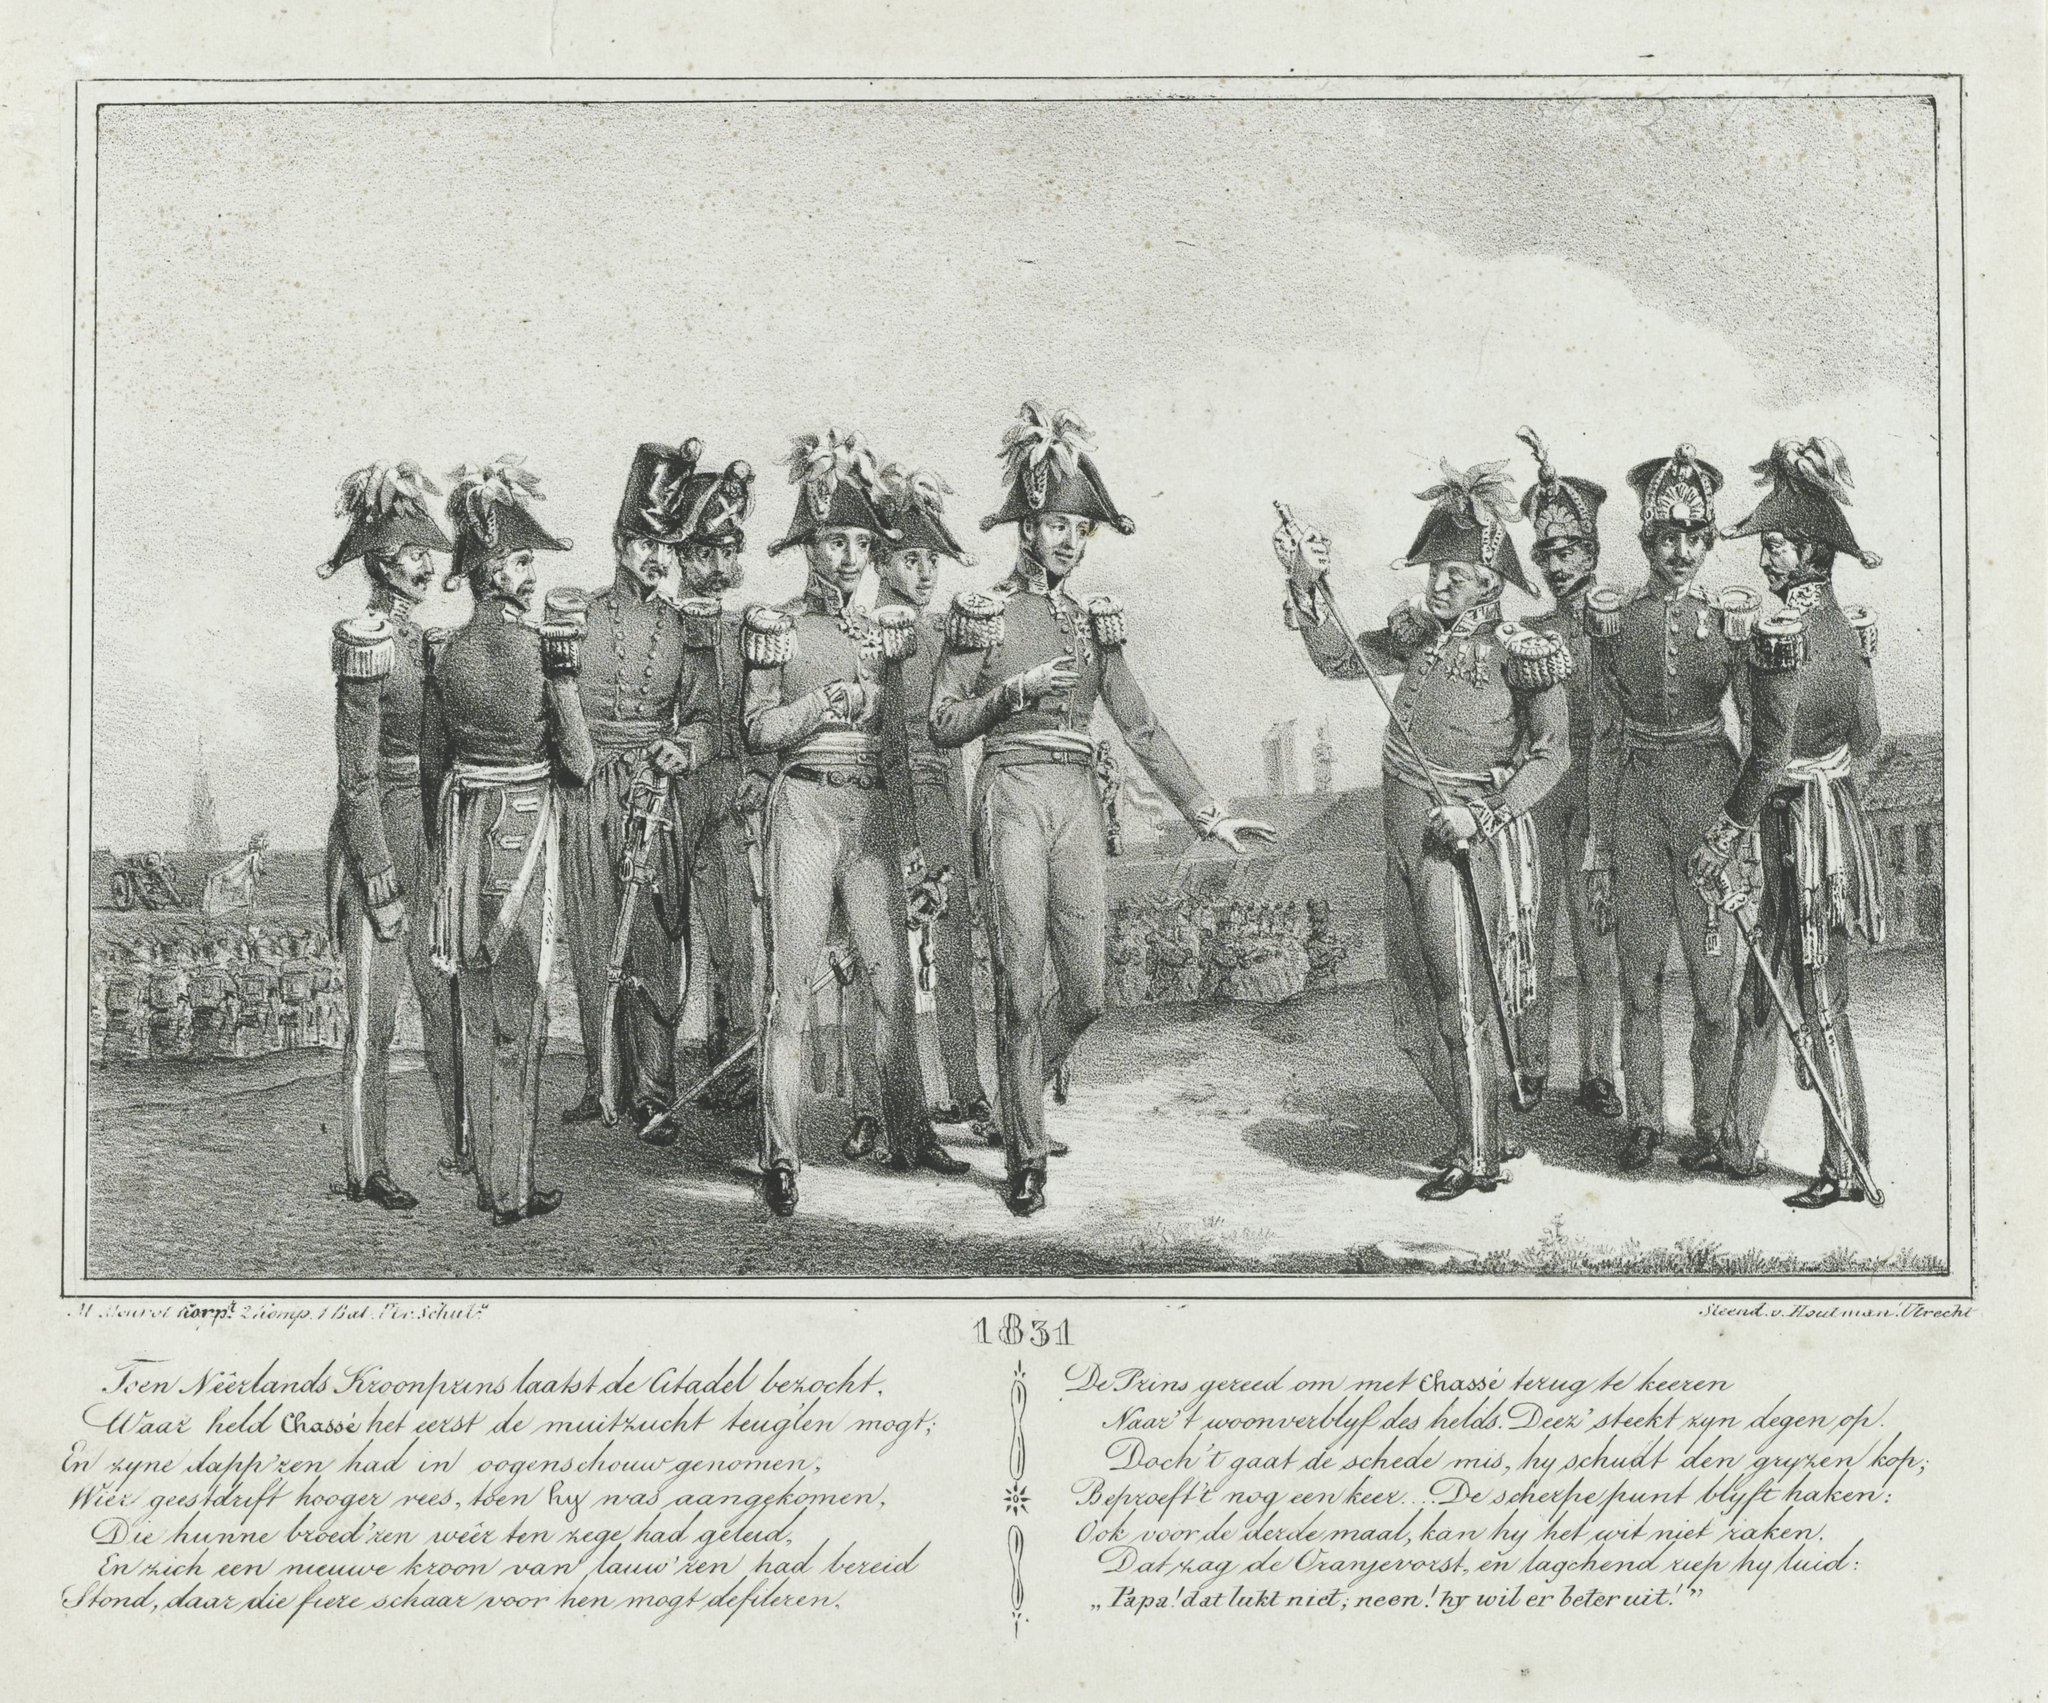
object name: print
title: Generaal Chassé tracht tevergeefs zijn degen in de schede te steken, 1813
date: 1831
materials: paper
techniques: lithograph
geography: utrecht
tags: david hendrik baron chassé, the hague, william ii of the netherlands, berlin, frederik (prins der nederlanden), hacking and thrusting weapons: rapier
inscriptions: collector's mark: Lugt 2228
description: Voorval tijdens het bezoek van de prins van Oranje en prins Frederik aan de Citadel van Antwerpen op 29 september 1831 als generaal Chassé tot drie keer toe tevergeefs tracht zijn degen in de schede te steken. Links de twee prinsen met hun gevolg, rechts Chassé met enkele hoge militairen. In het onderschrift een vers van twee keer zeven regels.